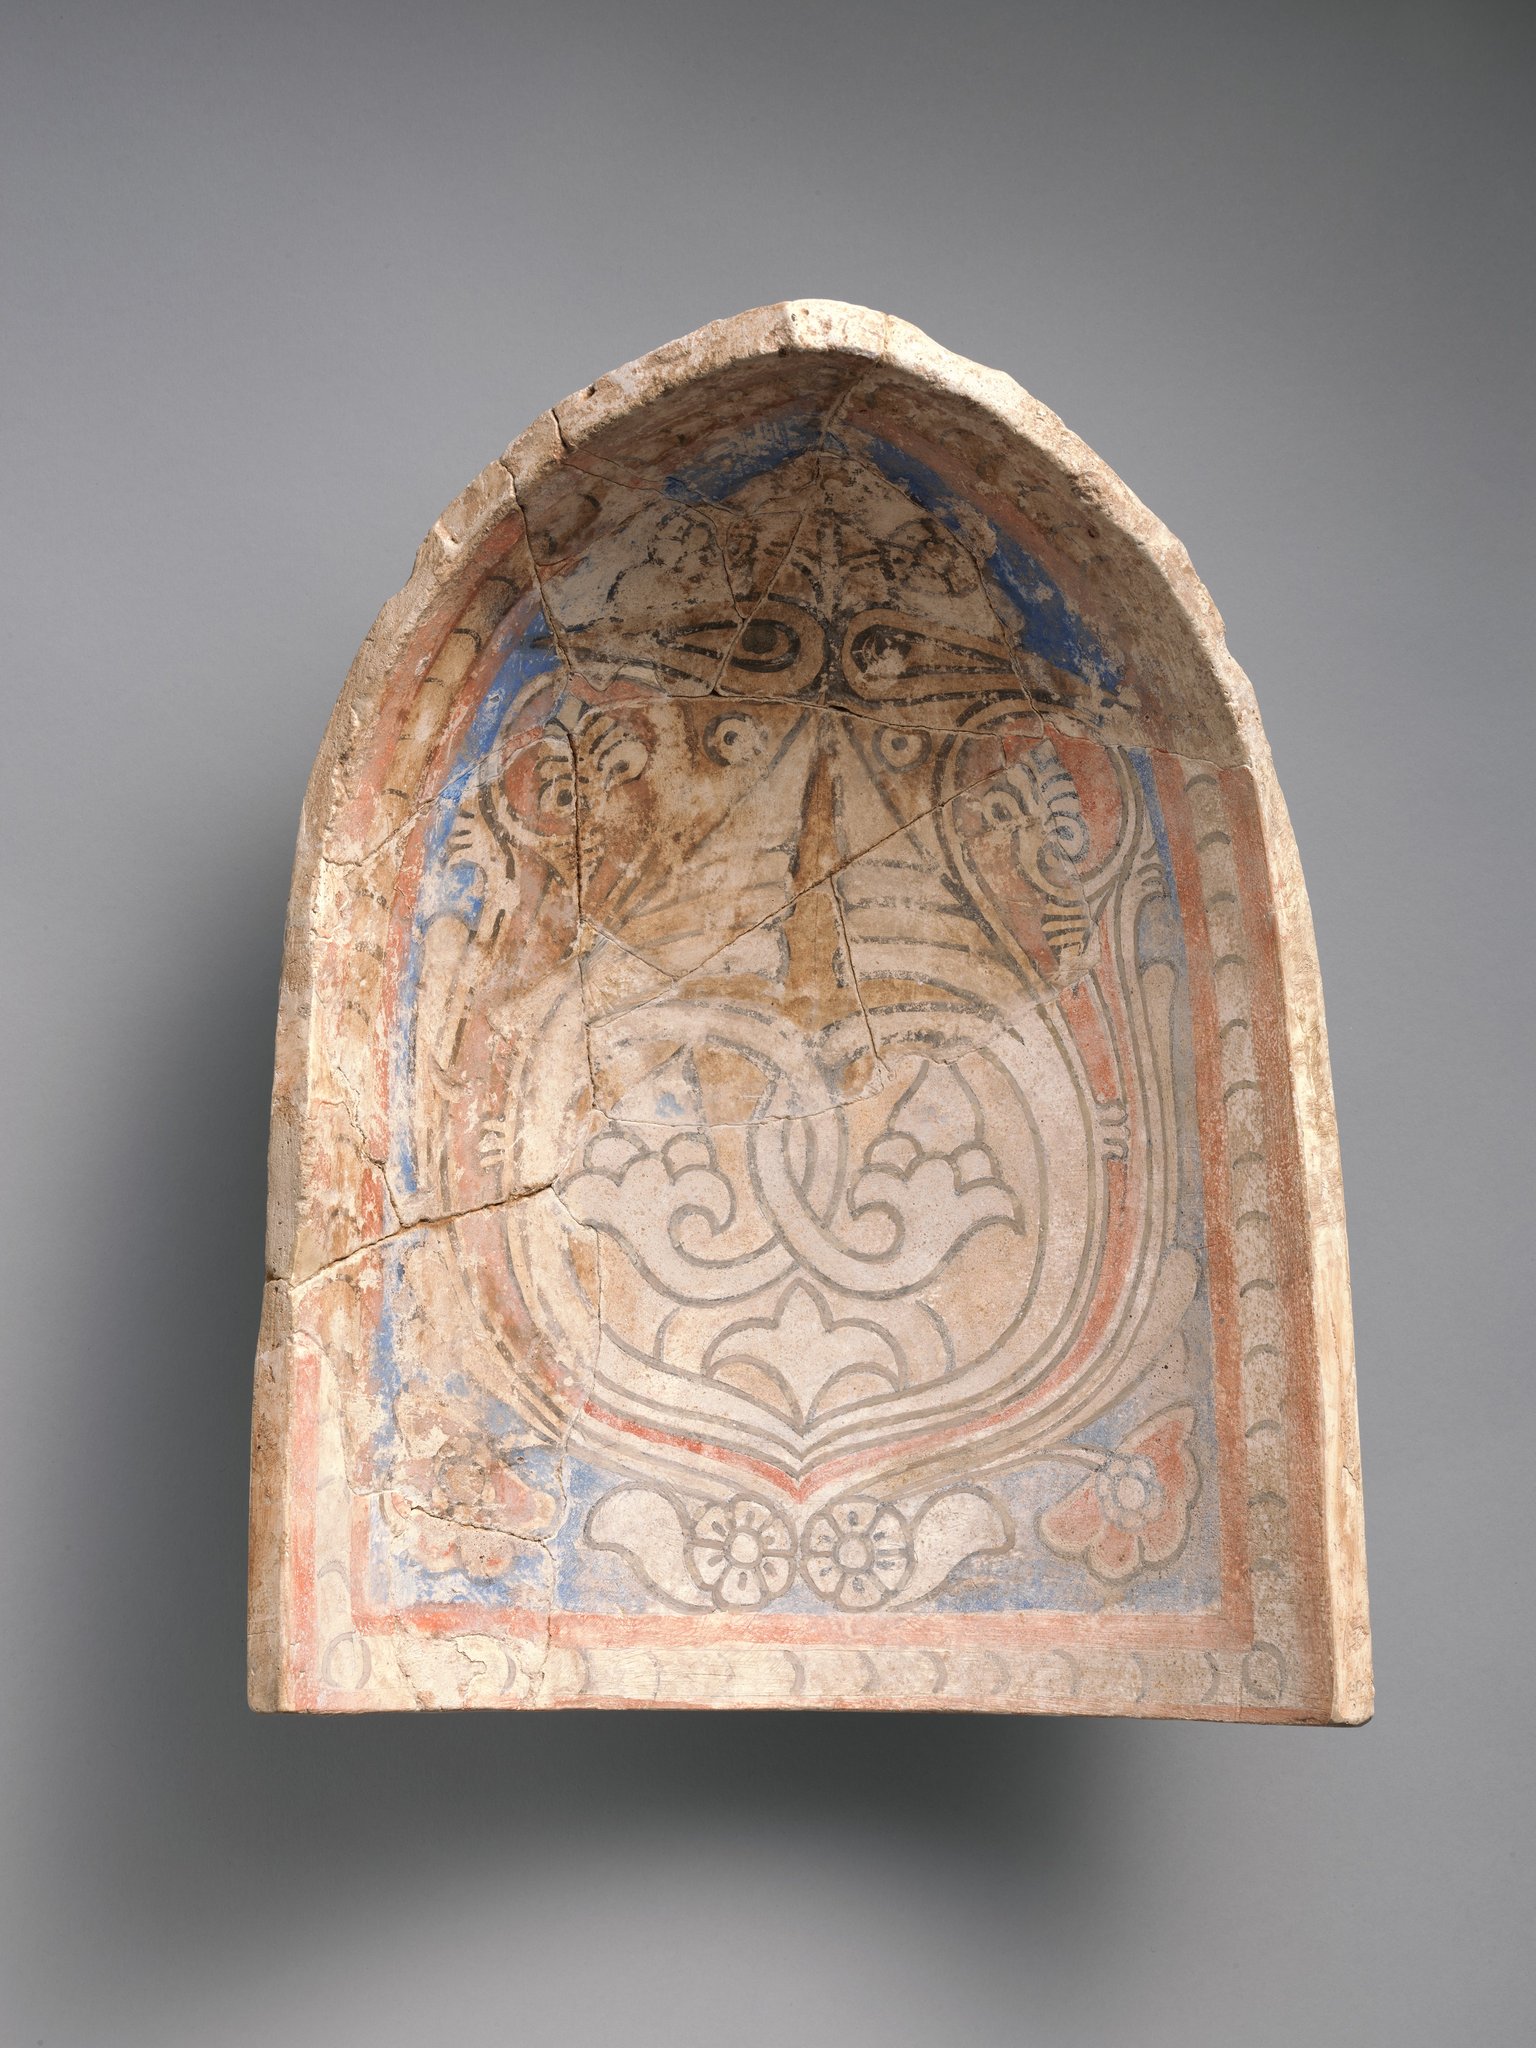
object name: squinch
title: Element from a Stalactite Squinch (Muqarnas)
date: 901-1000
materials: plaster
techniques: painting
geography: iran